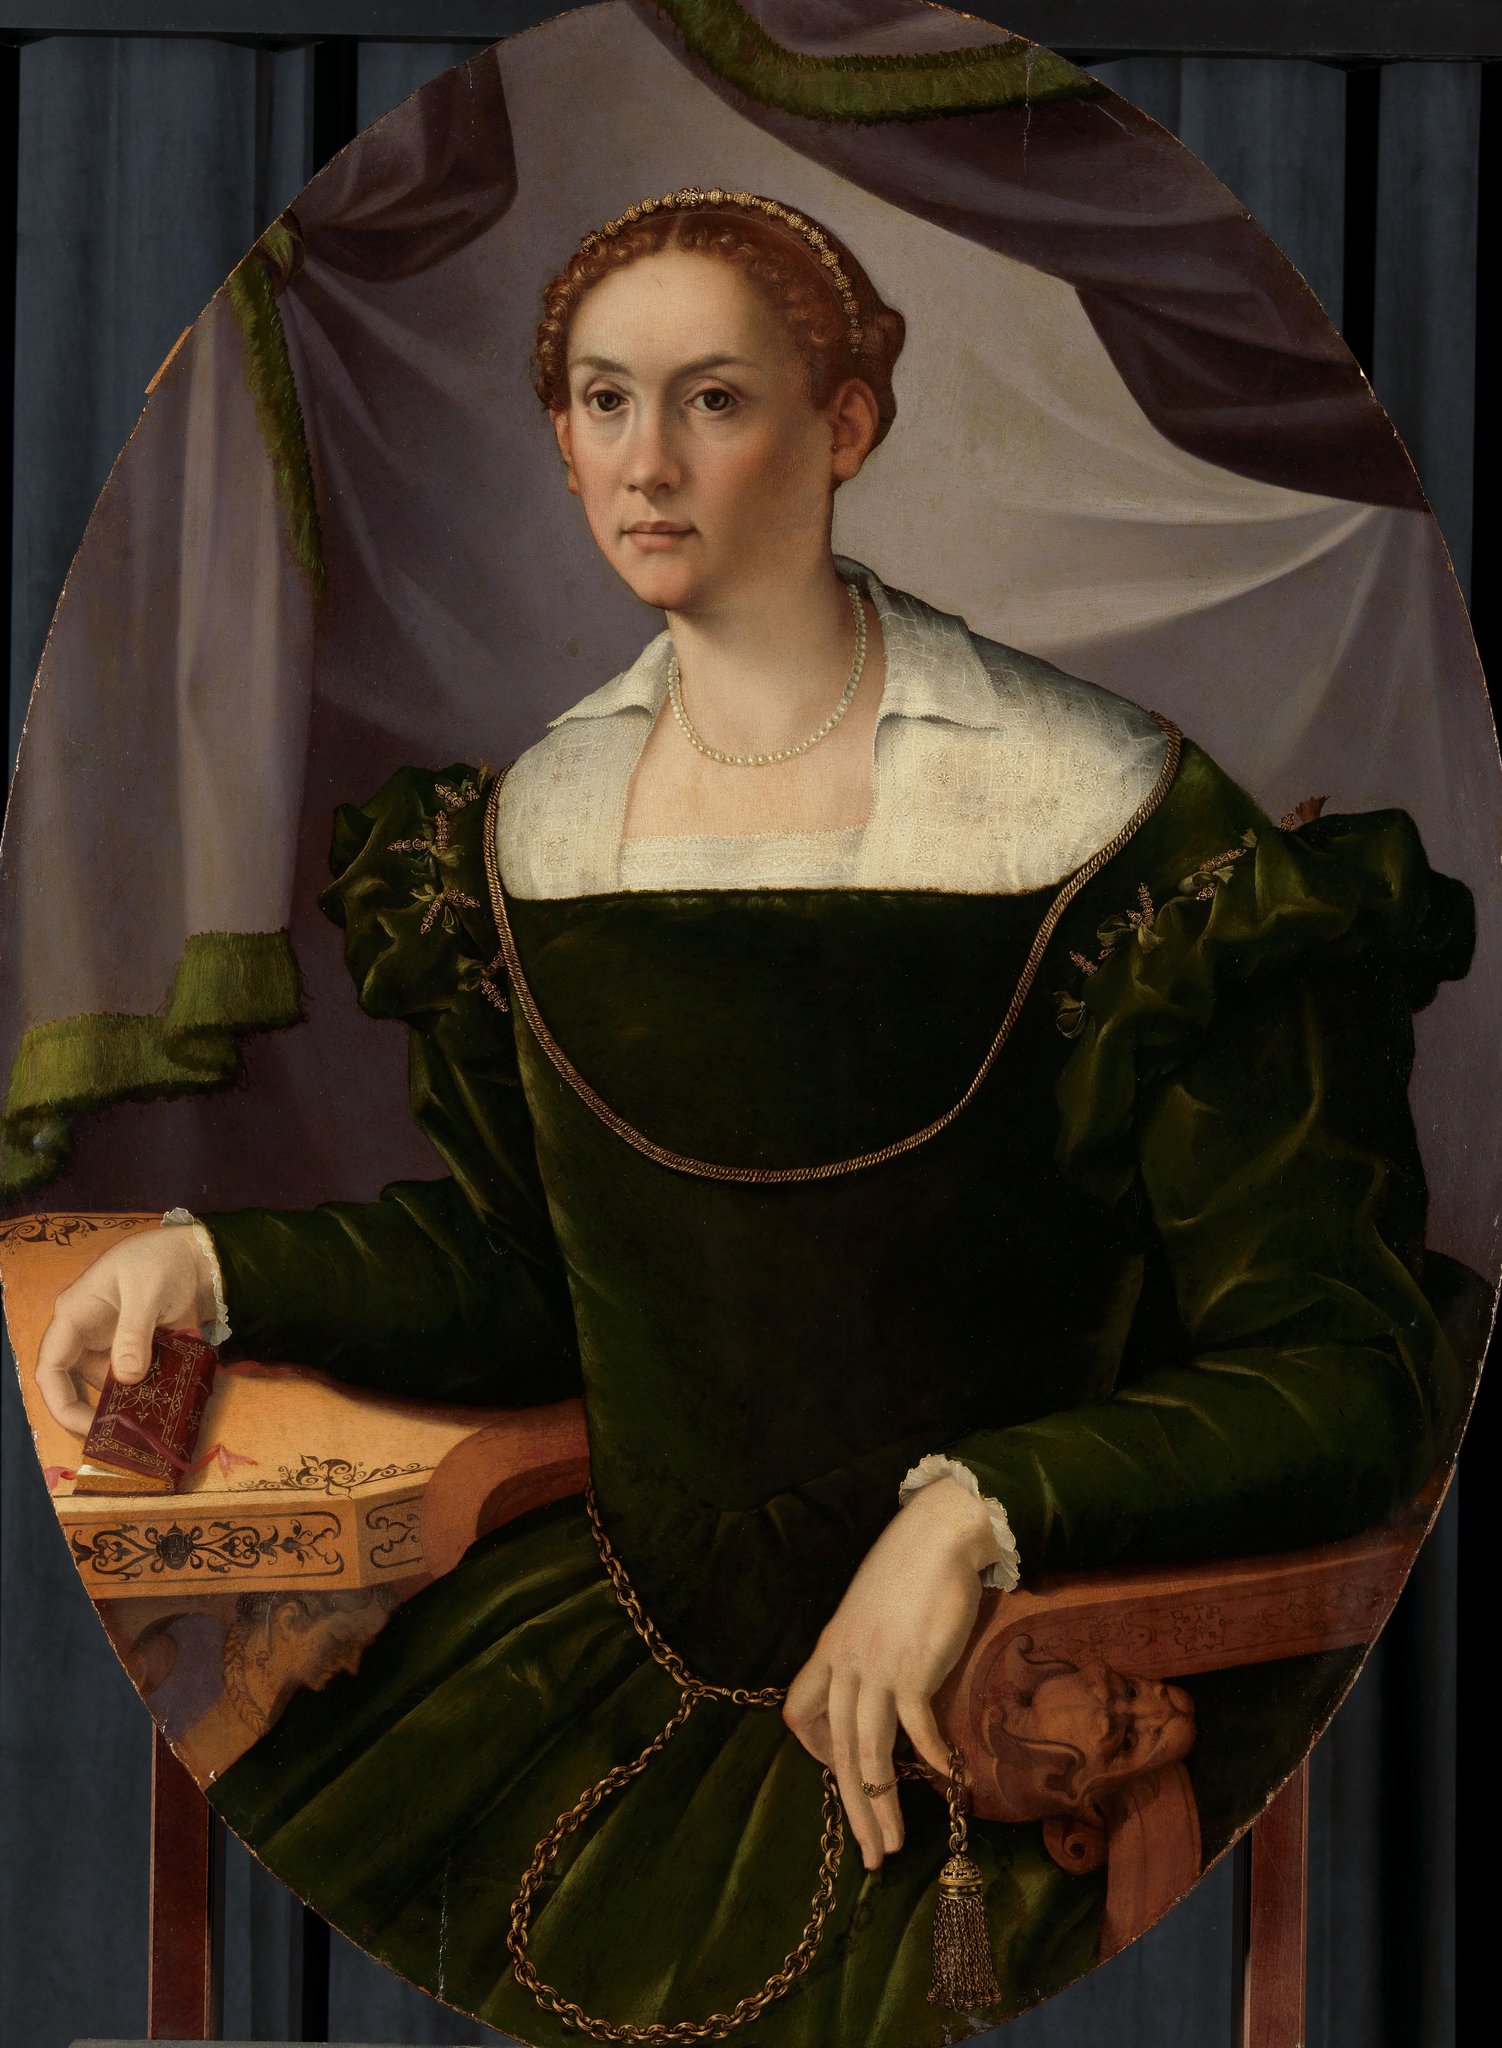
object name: painting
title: Portrait of a Woman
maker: carlo portelli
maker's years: 1500-1574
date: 1540-1565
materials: oil, panel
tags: book, anonymous historical person portrayed - bb - woman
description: The woman’s identity is unknown, but her velvet gown and jewellery bespeak her wealth. The long neck and slender fingers are typical features of Italian portraiture from this period. In the 16th century, portraits of this size were usually rectangular. The painting was probably cut into an oval shape in the 17th or 18th century.